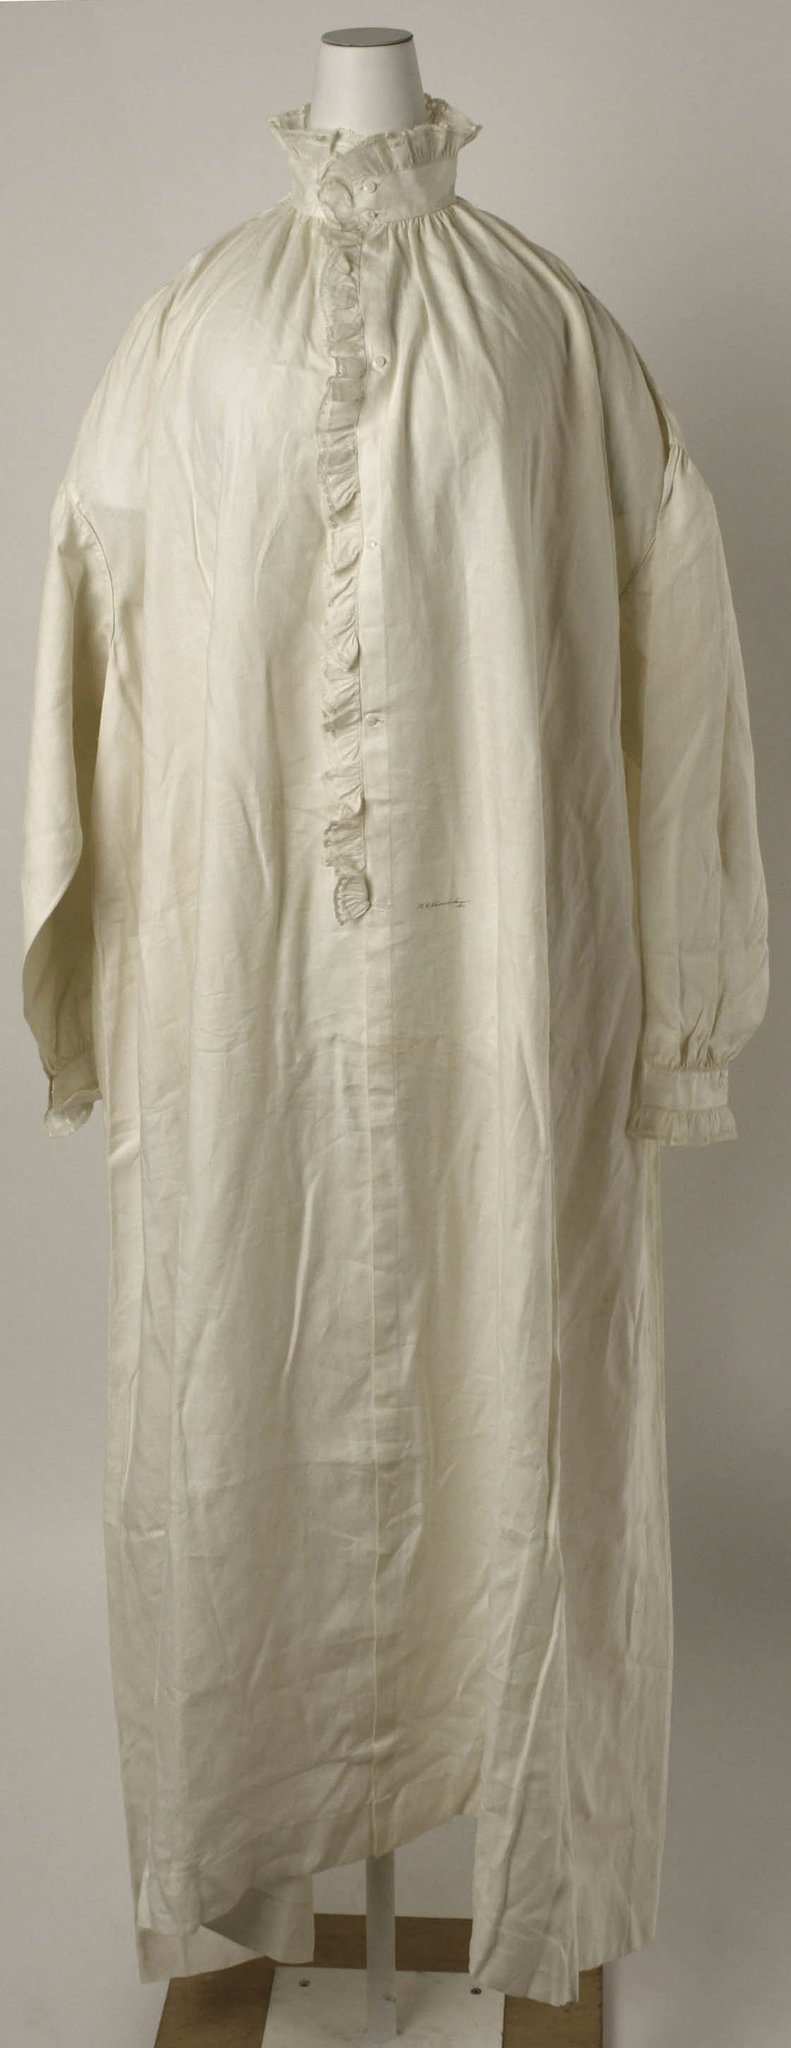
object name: nightgown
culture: american or european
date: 1850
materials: linen